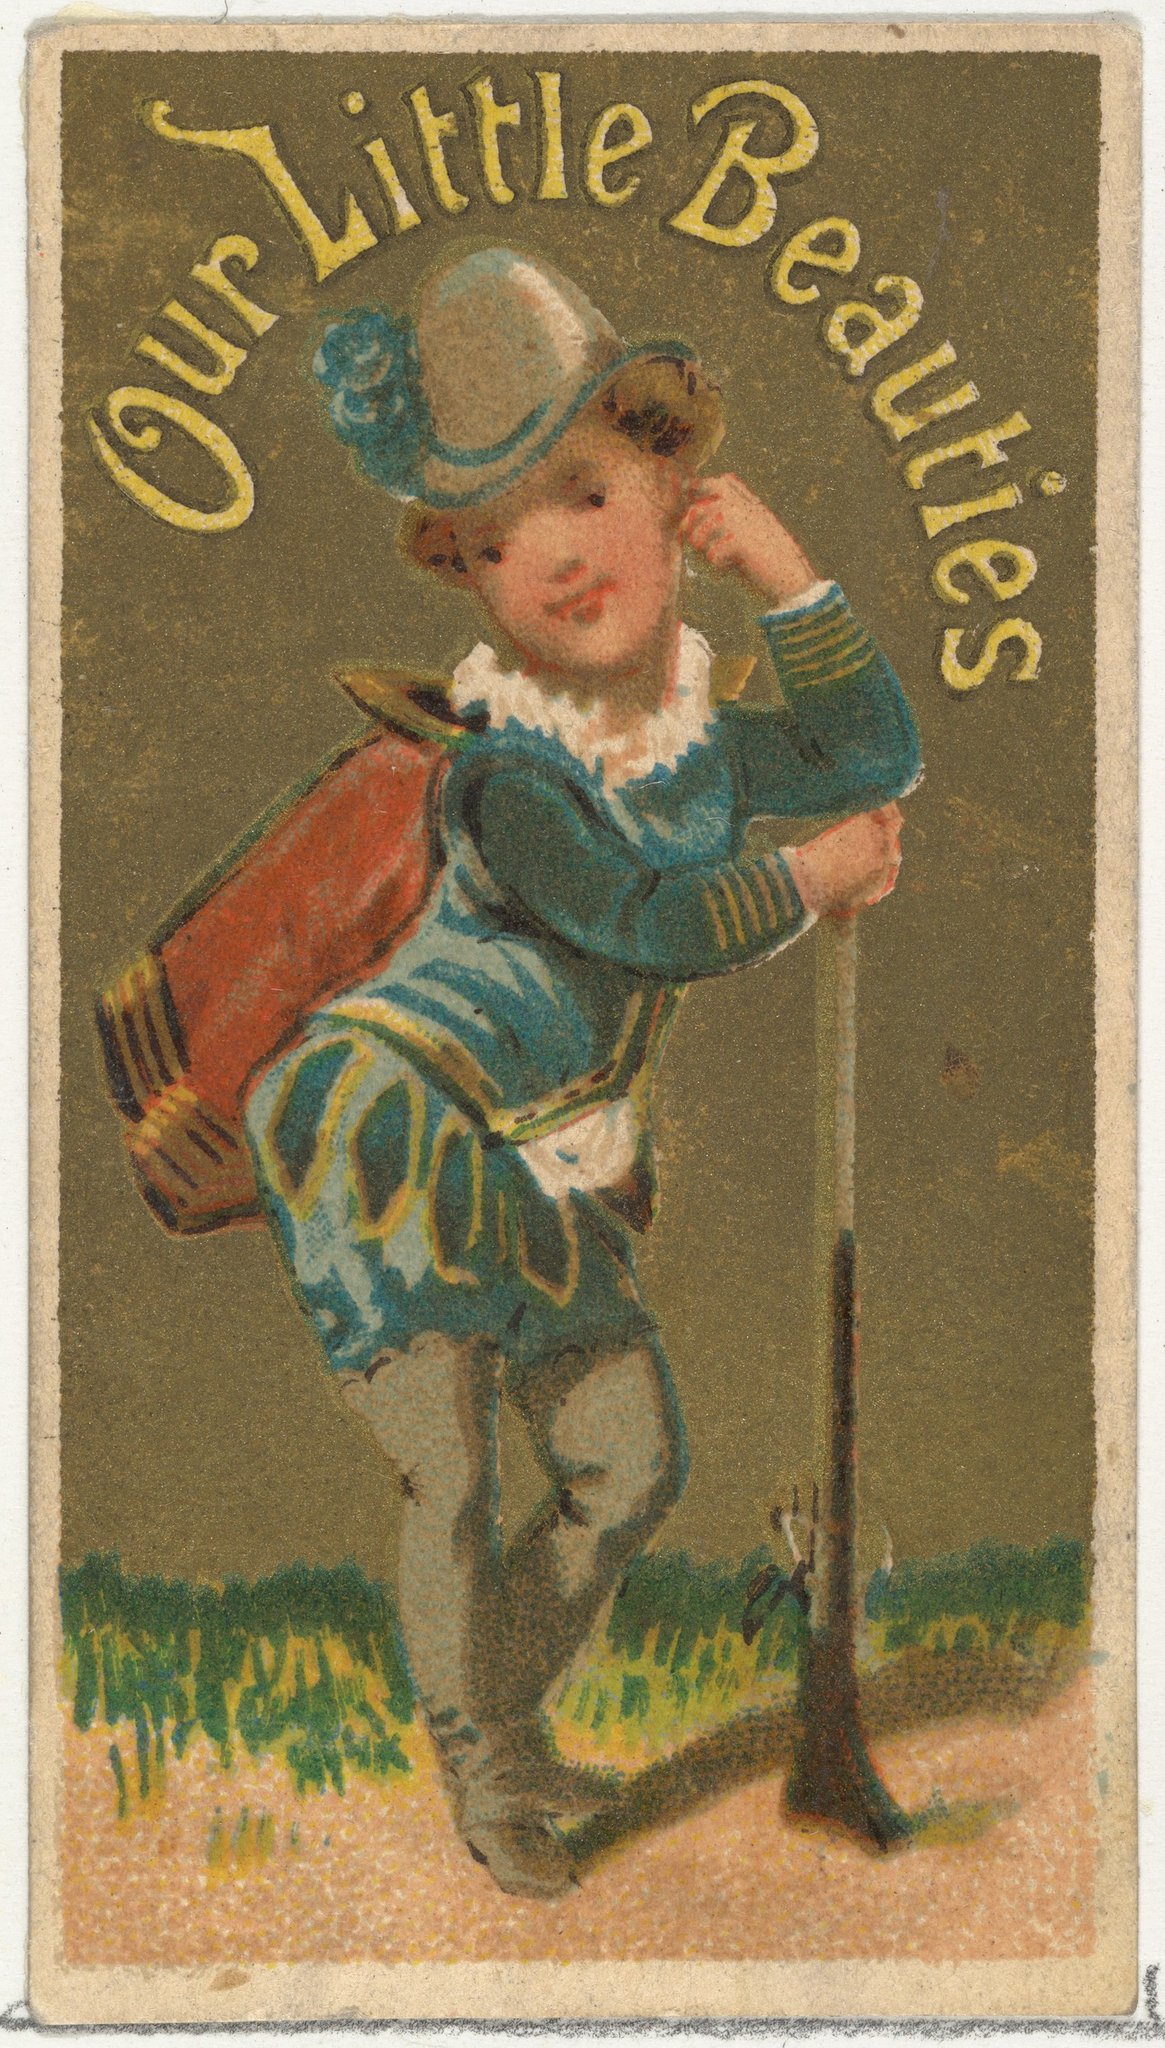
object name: print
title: From the Girls and Children series (N58) promoting Our Little Beauties Cigarettes for Allen & Ginter brand tobacco products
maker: allen & ginter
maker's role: publisher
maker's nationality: american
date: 1887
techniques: color lithograph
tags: girls